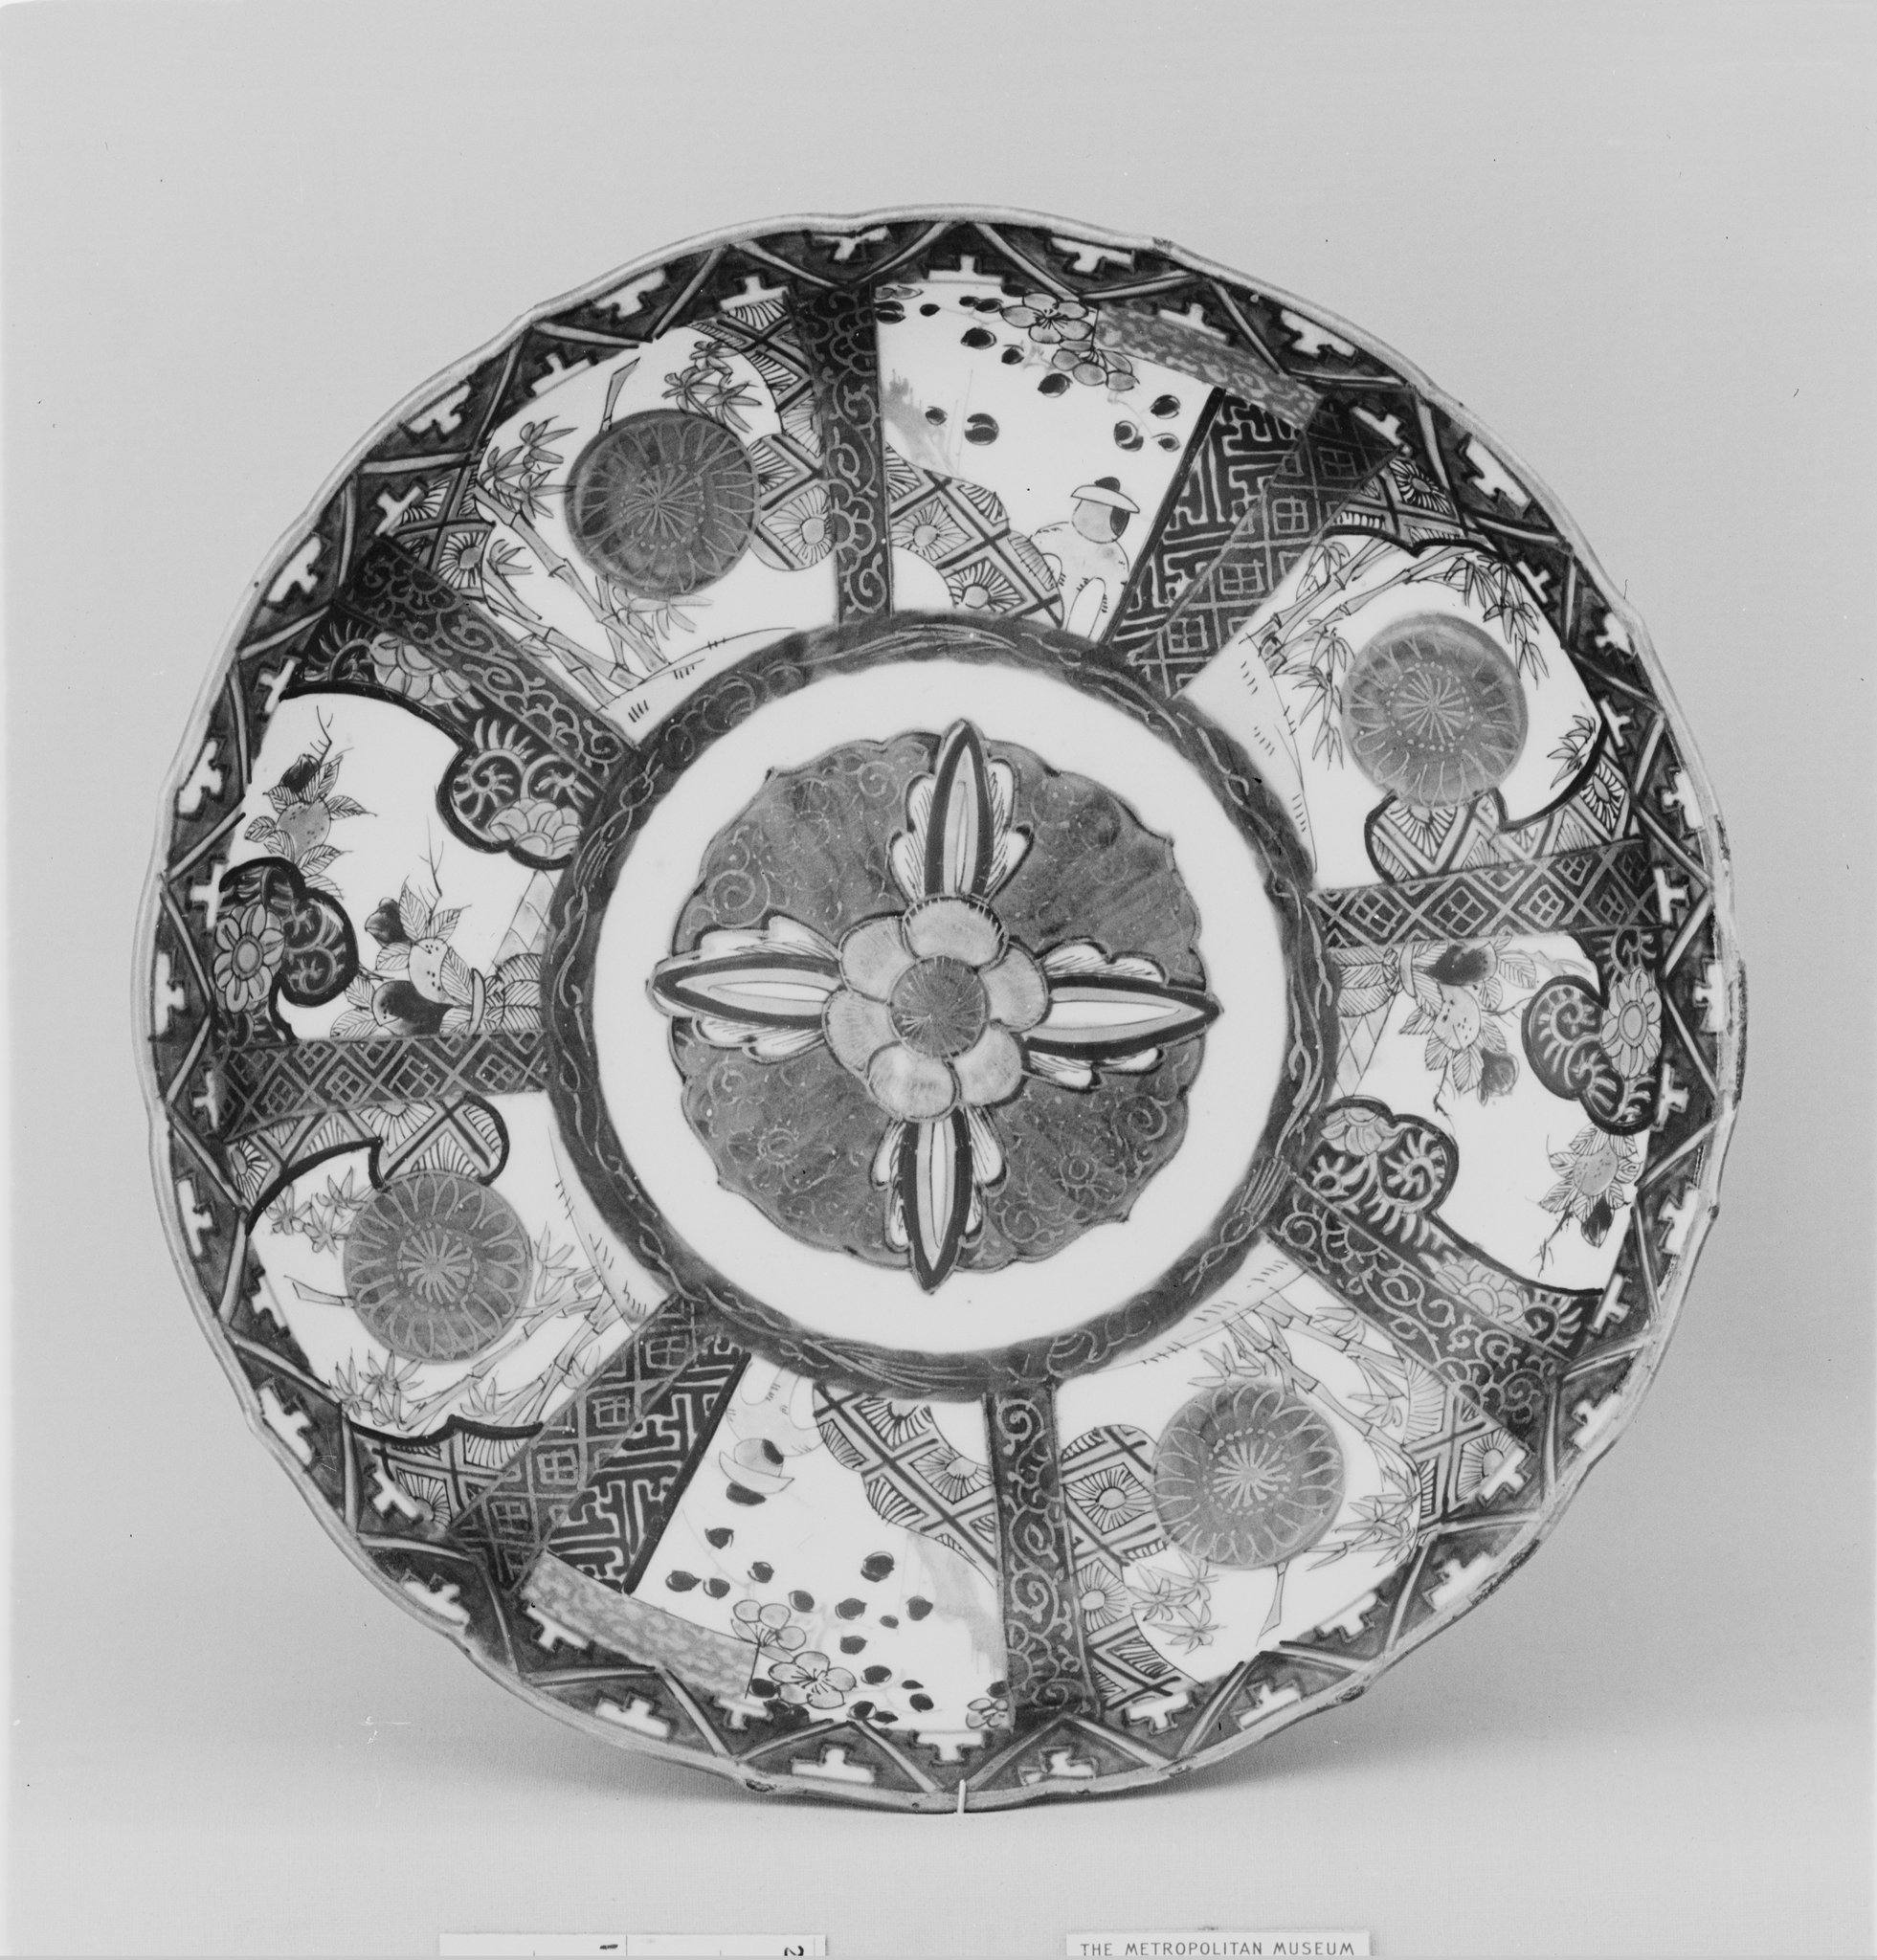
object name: plate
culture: japanese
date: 1700-1780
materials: glaze, porcelain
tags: flowers